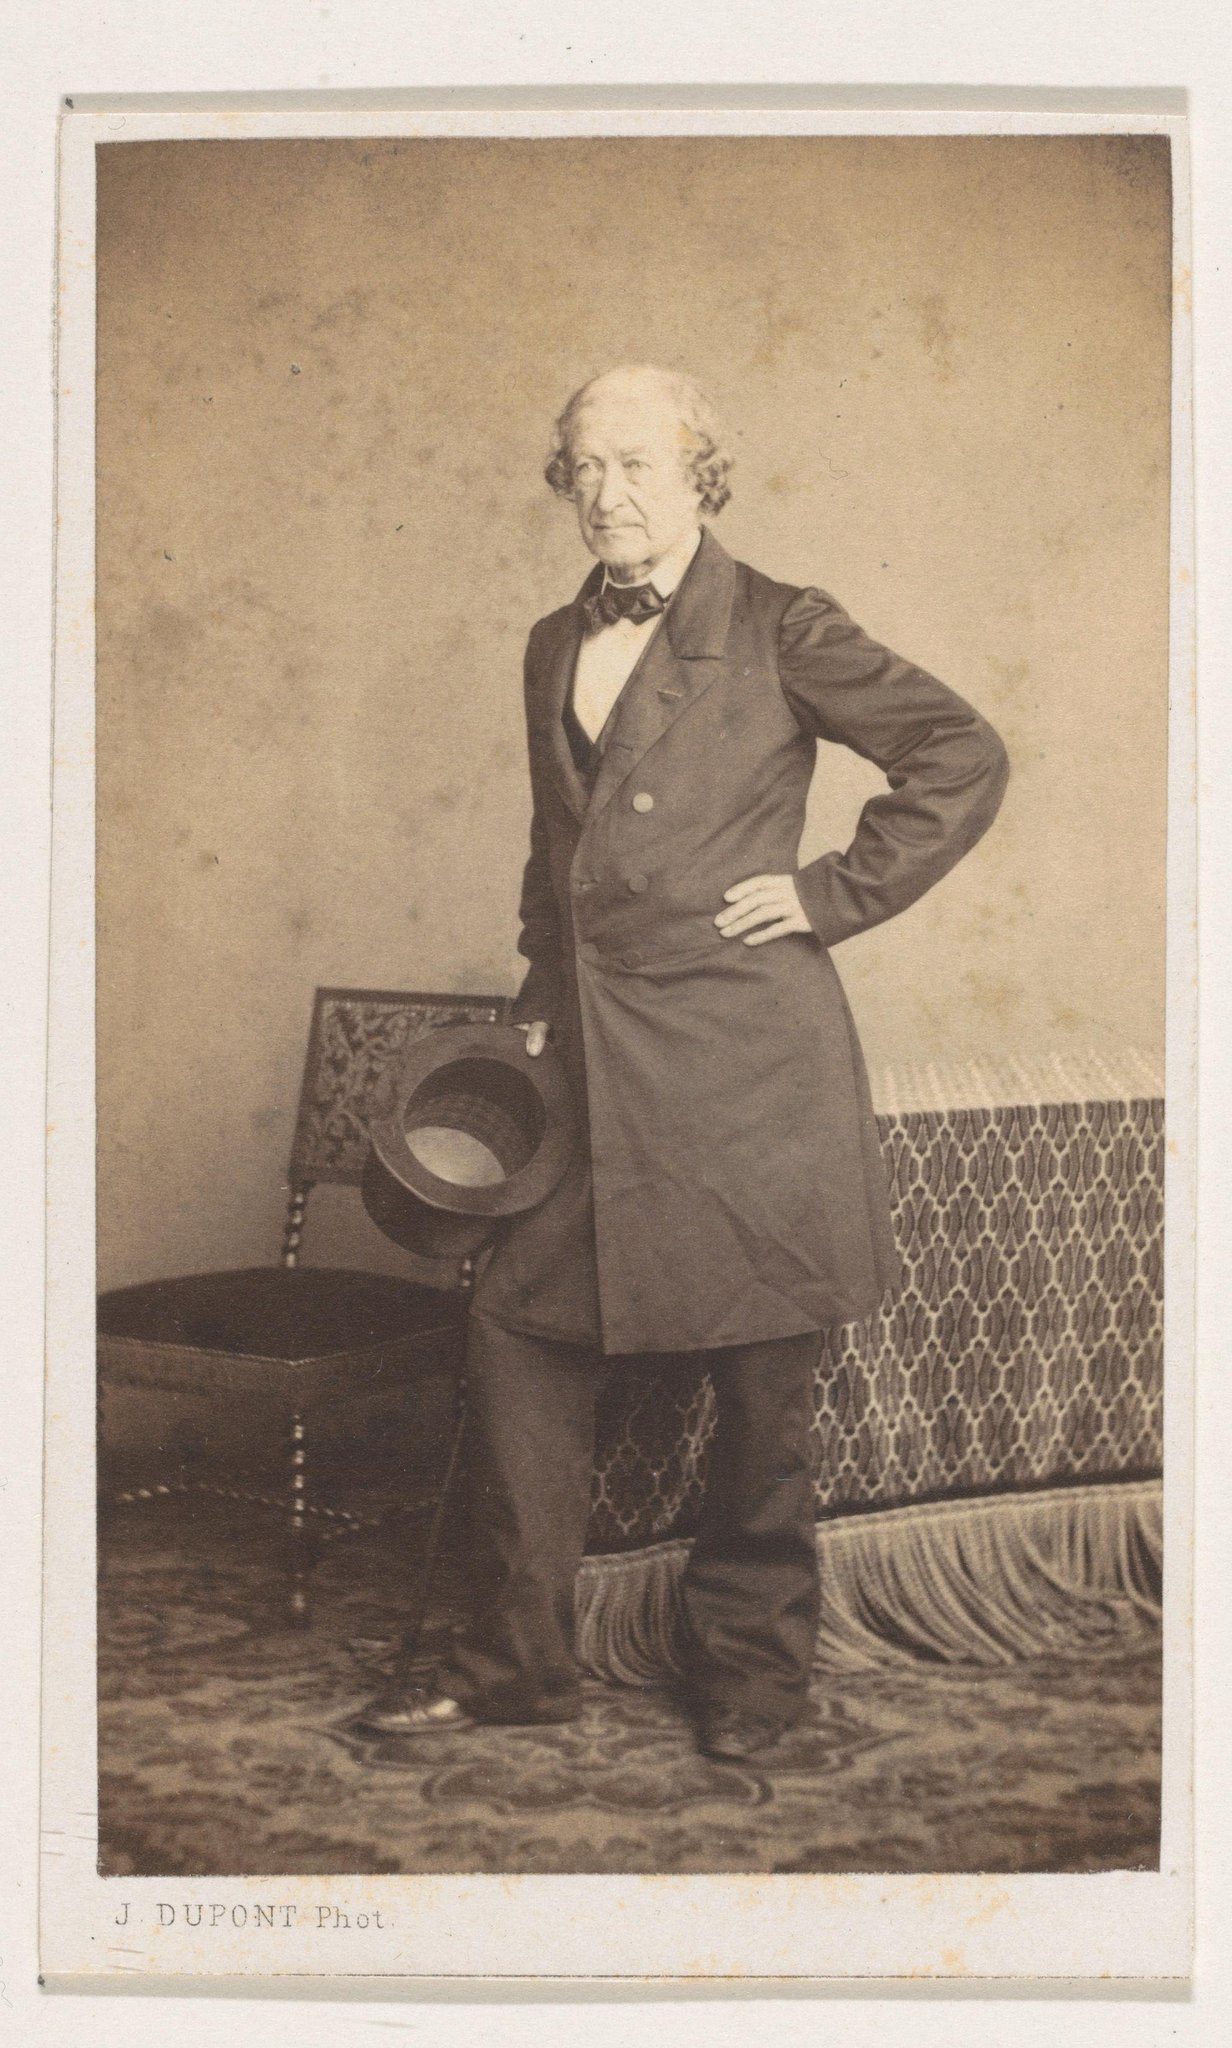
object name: photograph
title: Portret van de schilder Philippe-Jacques van Bree, ten voeten uit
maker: joseph dupont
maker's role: fotograaf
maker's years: 1818-1901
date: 1861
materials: cardboard, paper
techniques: albumen print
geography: antwerp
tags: antwerp, brussels, print maker, draughtsman, philippus jacobus van bree, historical persons, portrait, self-portrait of painter, portrait, self-portrait of artist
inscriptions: inscription: ‘ETABLISSEMENT PHOTOGRAPHIQUE/ de/ J. DUPONT/ Place de Meir 32/ ANVERS/ Maison fondée en 1853’